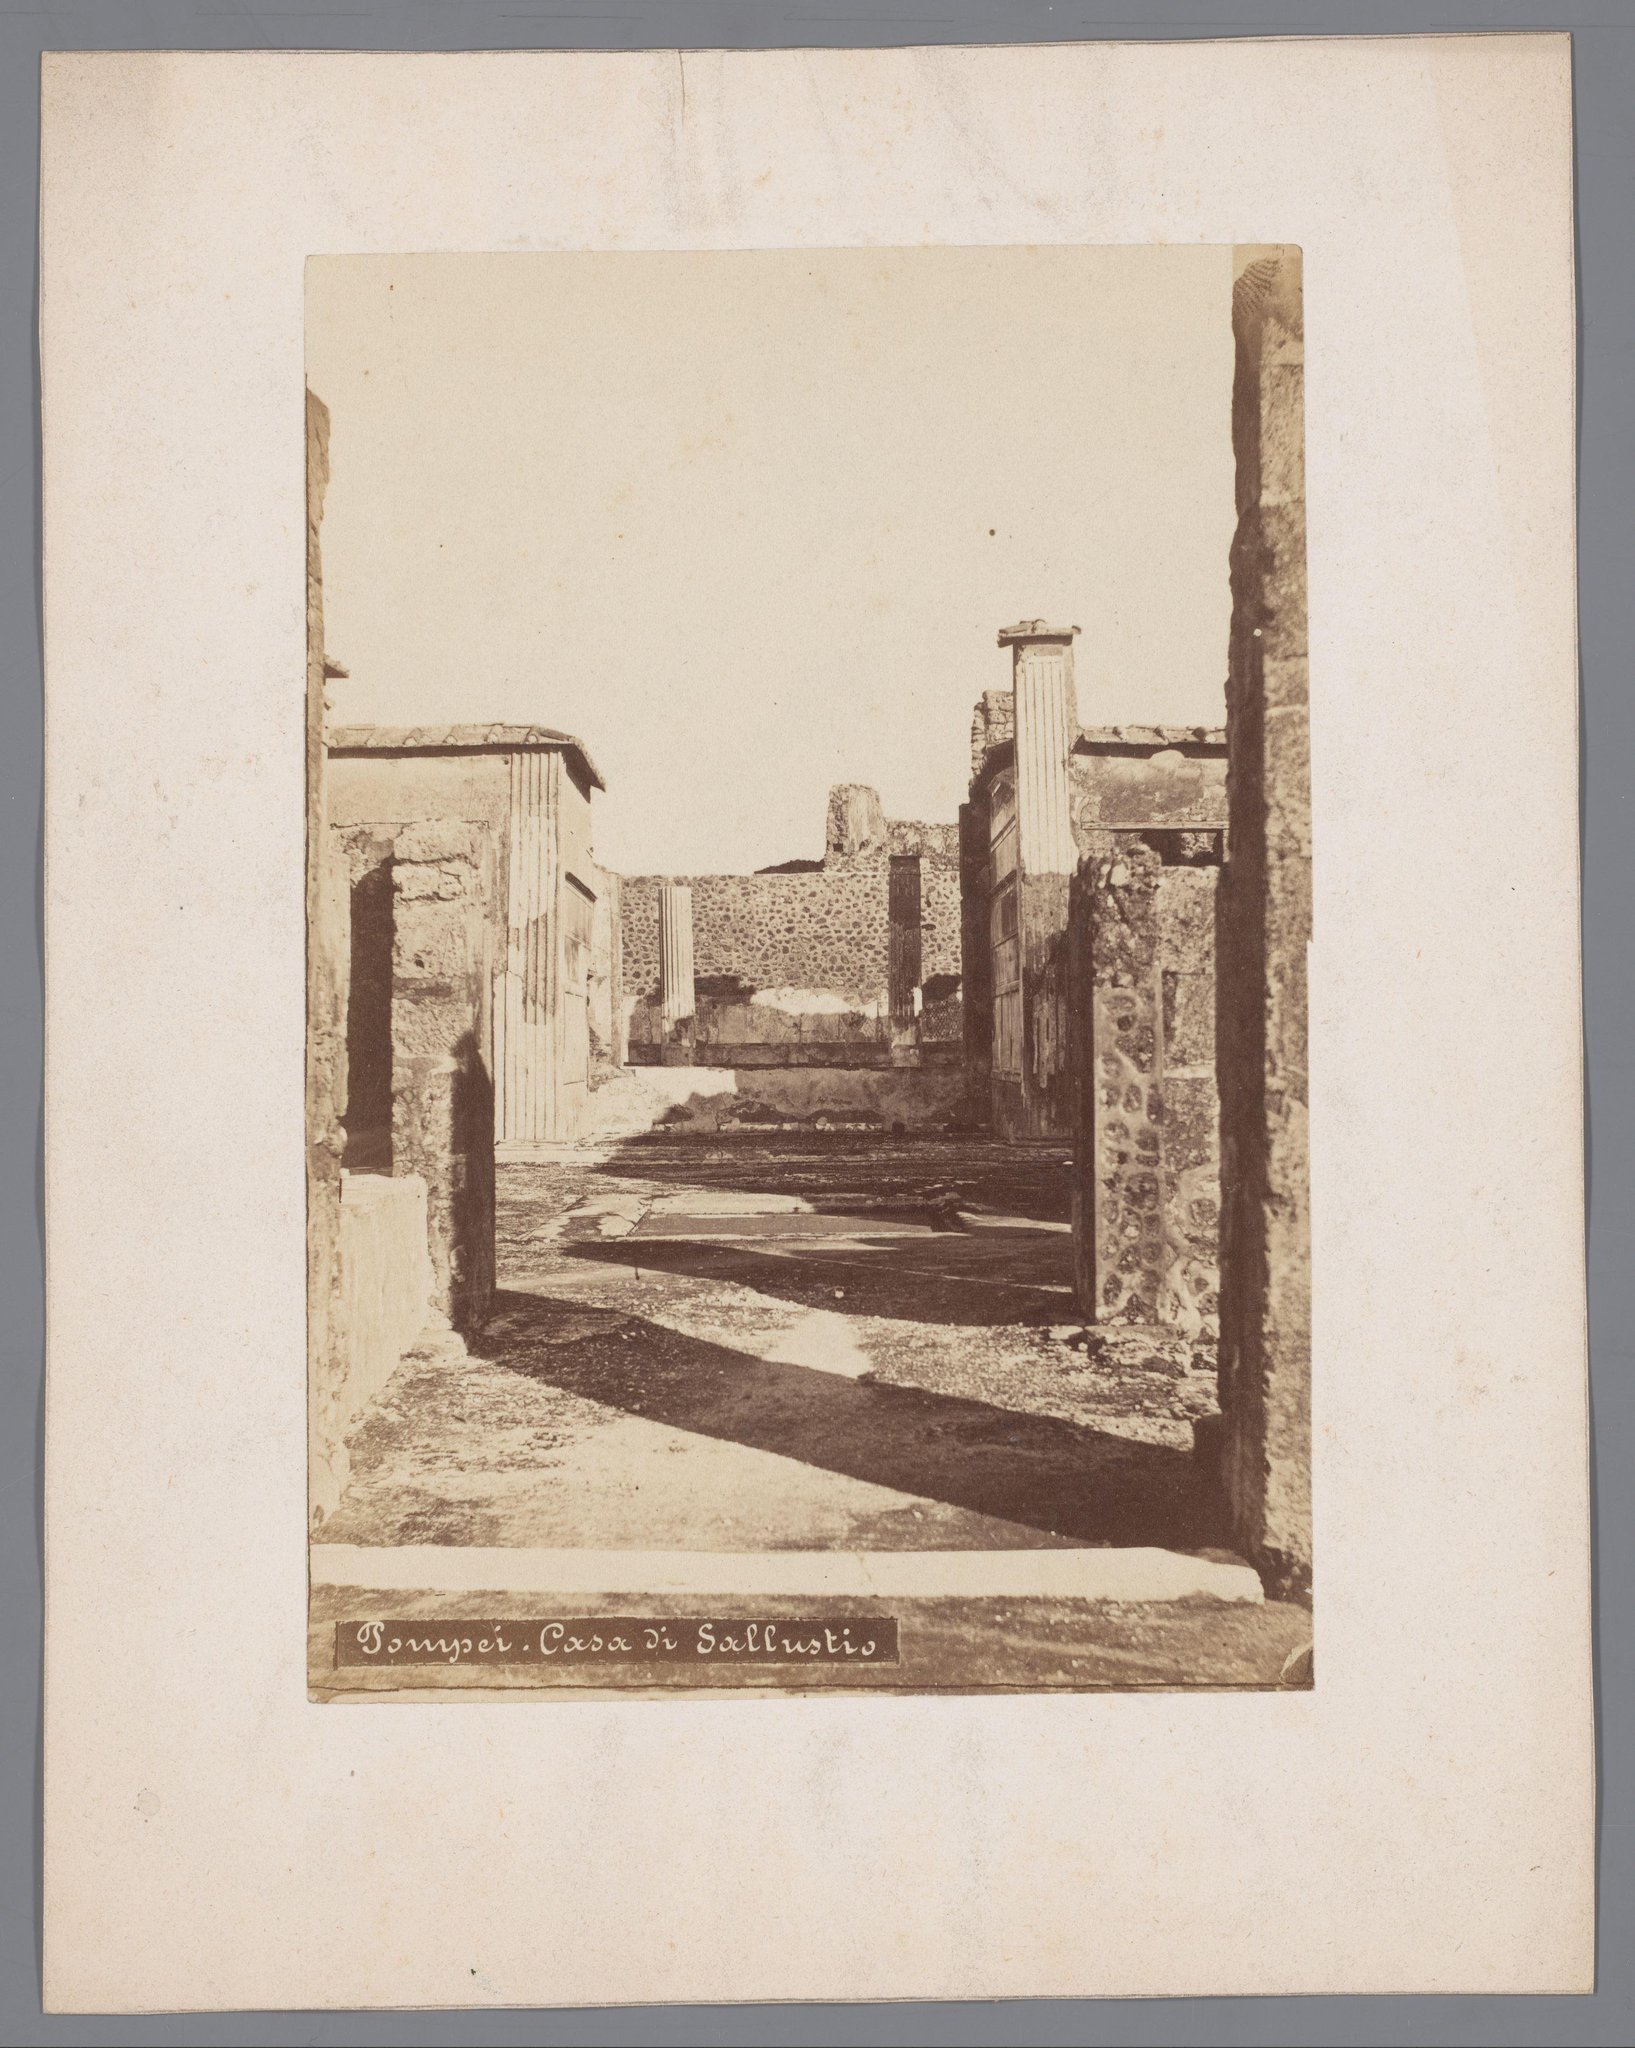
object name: photograph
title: Restanten van het huis van Sallustio te Pompeï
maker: giorgio sommer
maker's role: fotograaf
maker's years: 1834-1914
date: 1857-1914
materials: cardboard, paper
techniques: albumen print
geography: pompeii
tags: urban housing, ruin of a building ~ architecture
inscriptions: inscription: ‘10’, collector's mark: ‘VOSMAER’